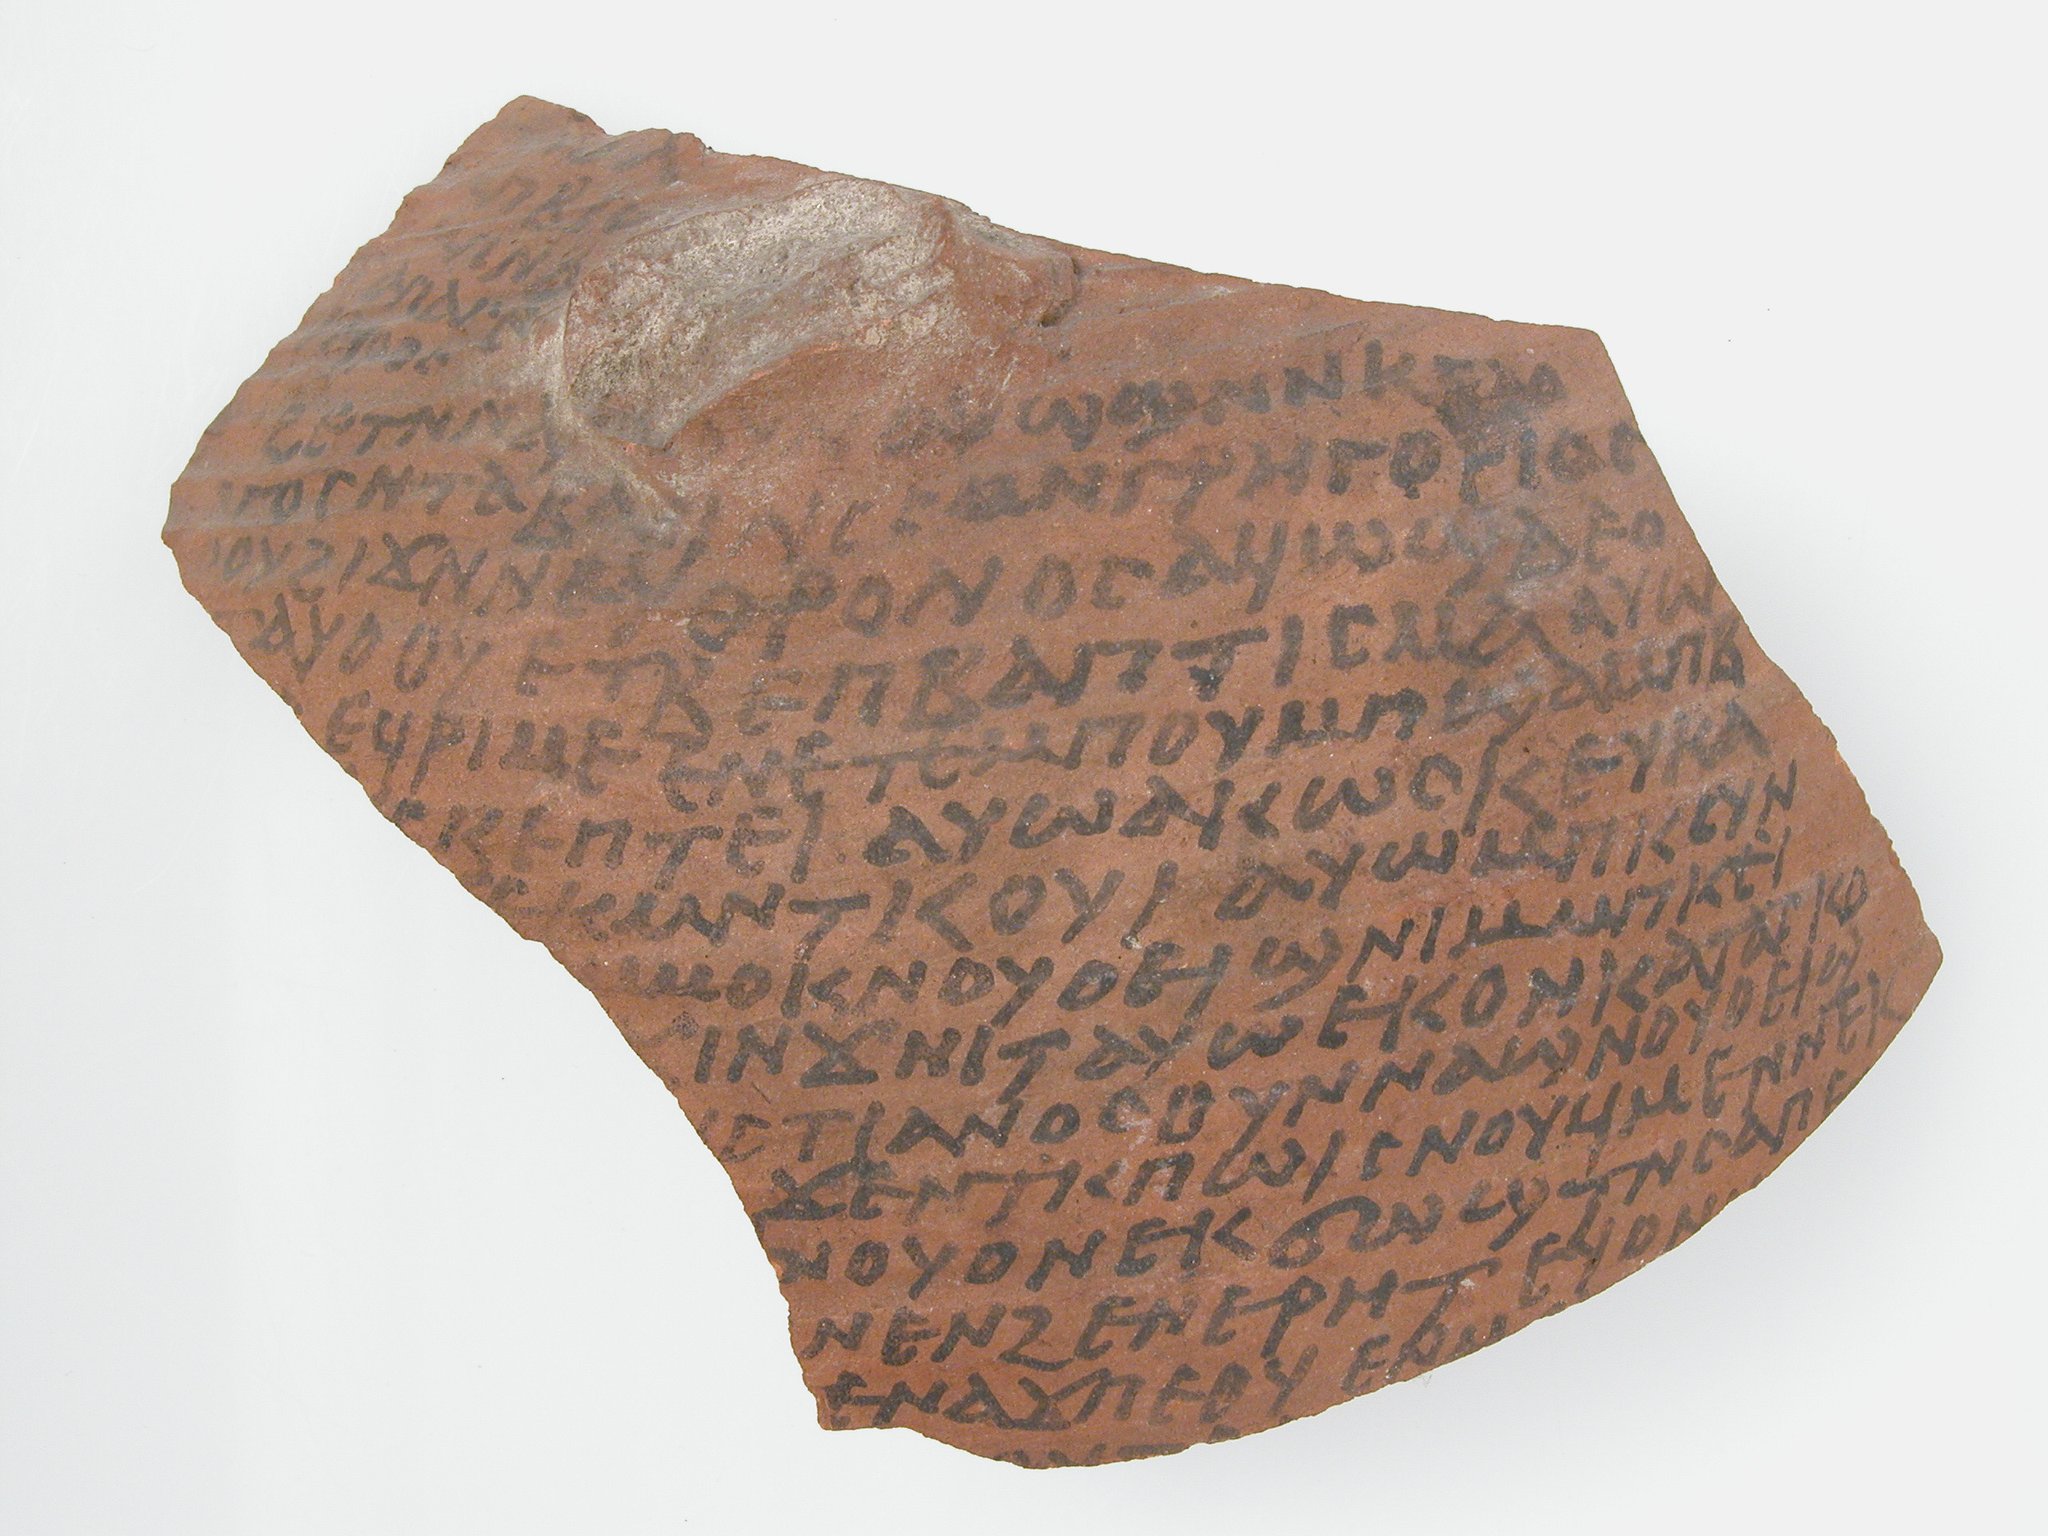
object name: ostrakon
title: Ostrakon with Text from the Biography of Severus of Antioch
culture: coptic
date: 600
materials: ink, pottery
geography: egypt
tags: coptic,documents